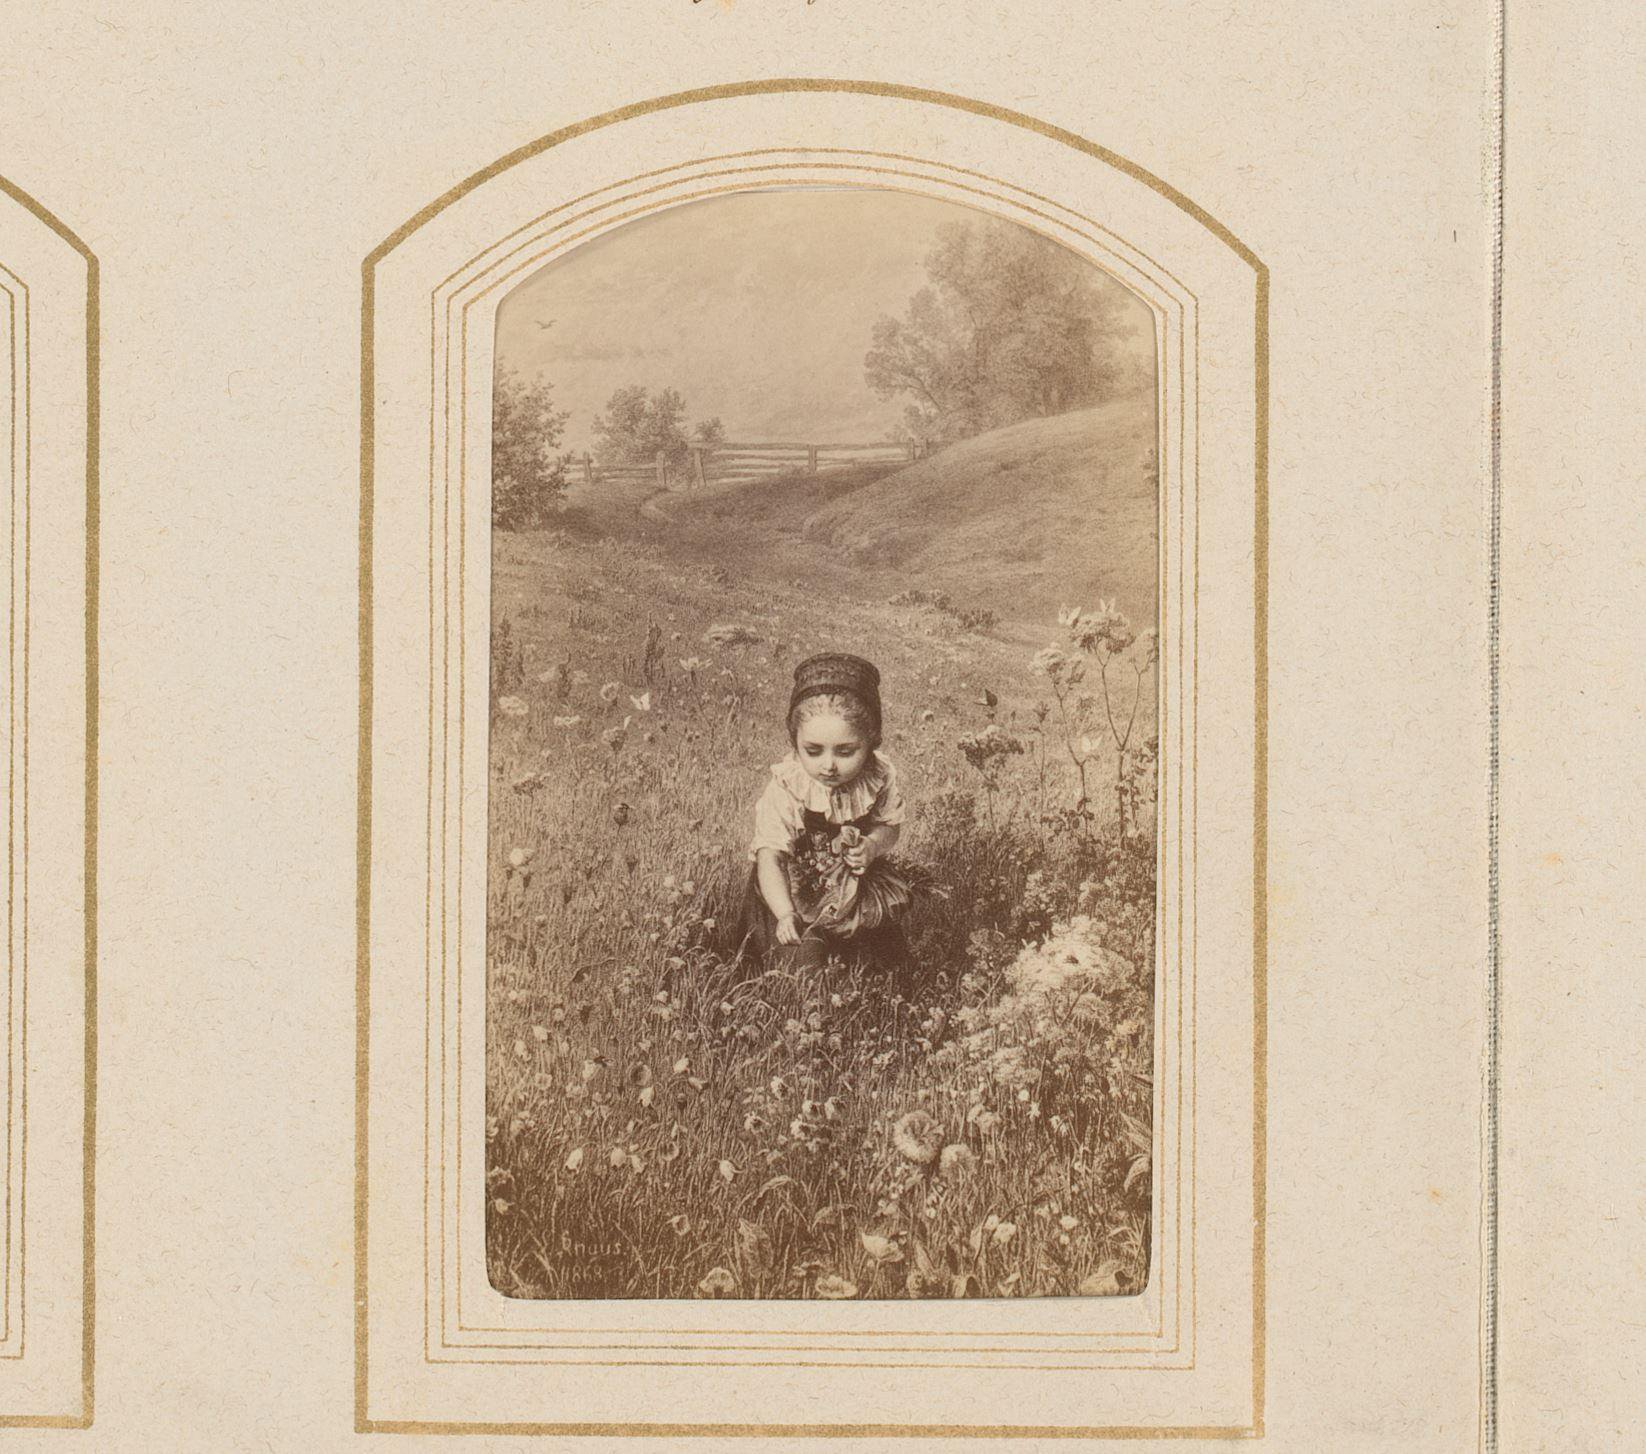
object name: photograph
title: Fotoreproductie van een schilderij van een kind dat bloemen plukt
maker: Anonymous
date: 1870-1900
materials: cardboard, photographic support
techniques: albumen print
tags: picking flowers, child, painting, drawing and the graphic arts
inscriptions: annotation: ‘Ein kleine [...]’